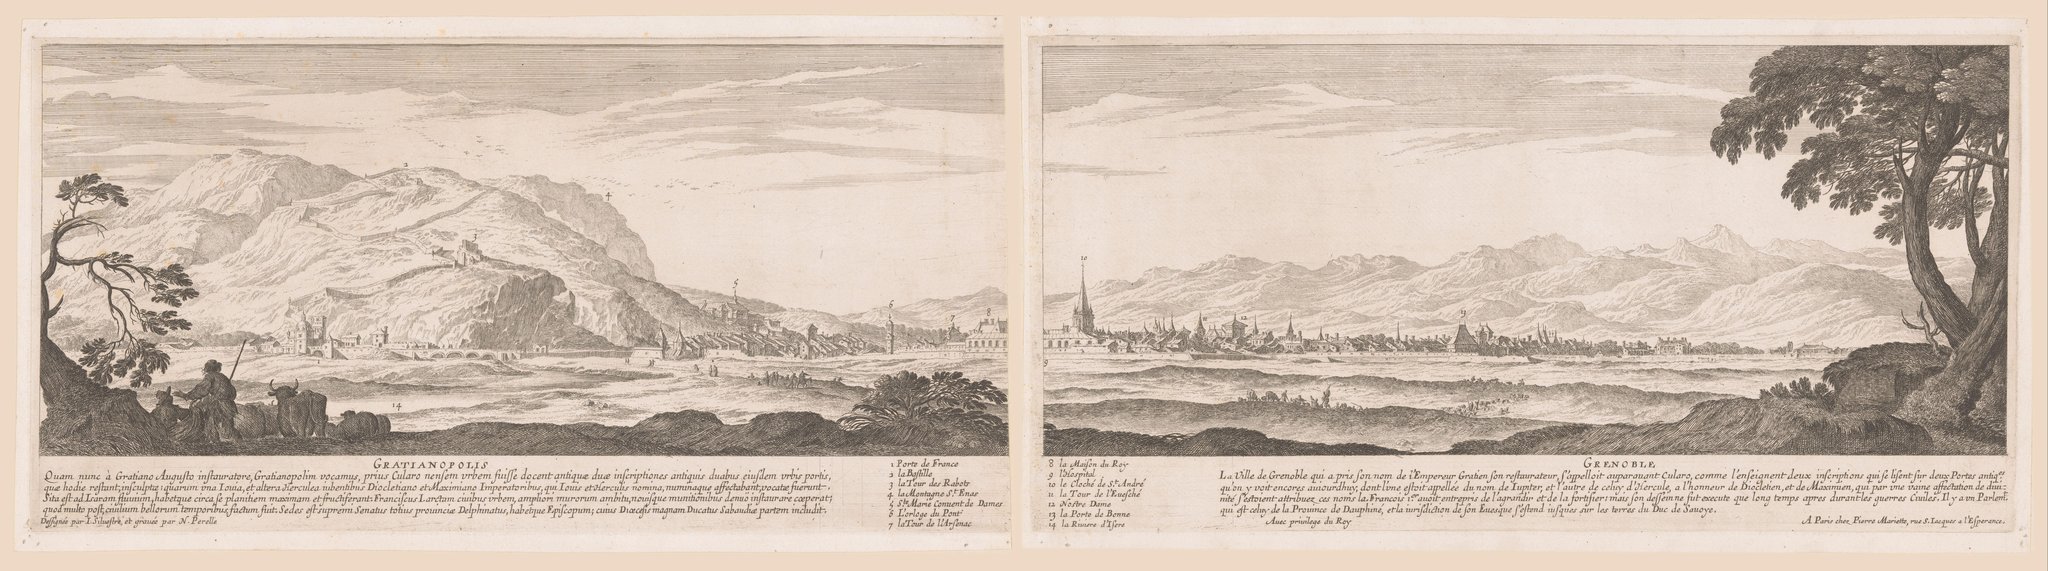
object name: print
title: Gezicht op Grenoble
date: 1641-1695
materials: paper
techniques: engraving, etching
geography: france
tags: landscapes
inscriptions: collector's mark: Lugt 240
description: Dit object is omwille van een betere presentatie virtueel samengevoegd, maar bestaat fysiek uit losse onderdelen.